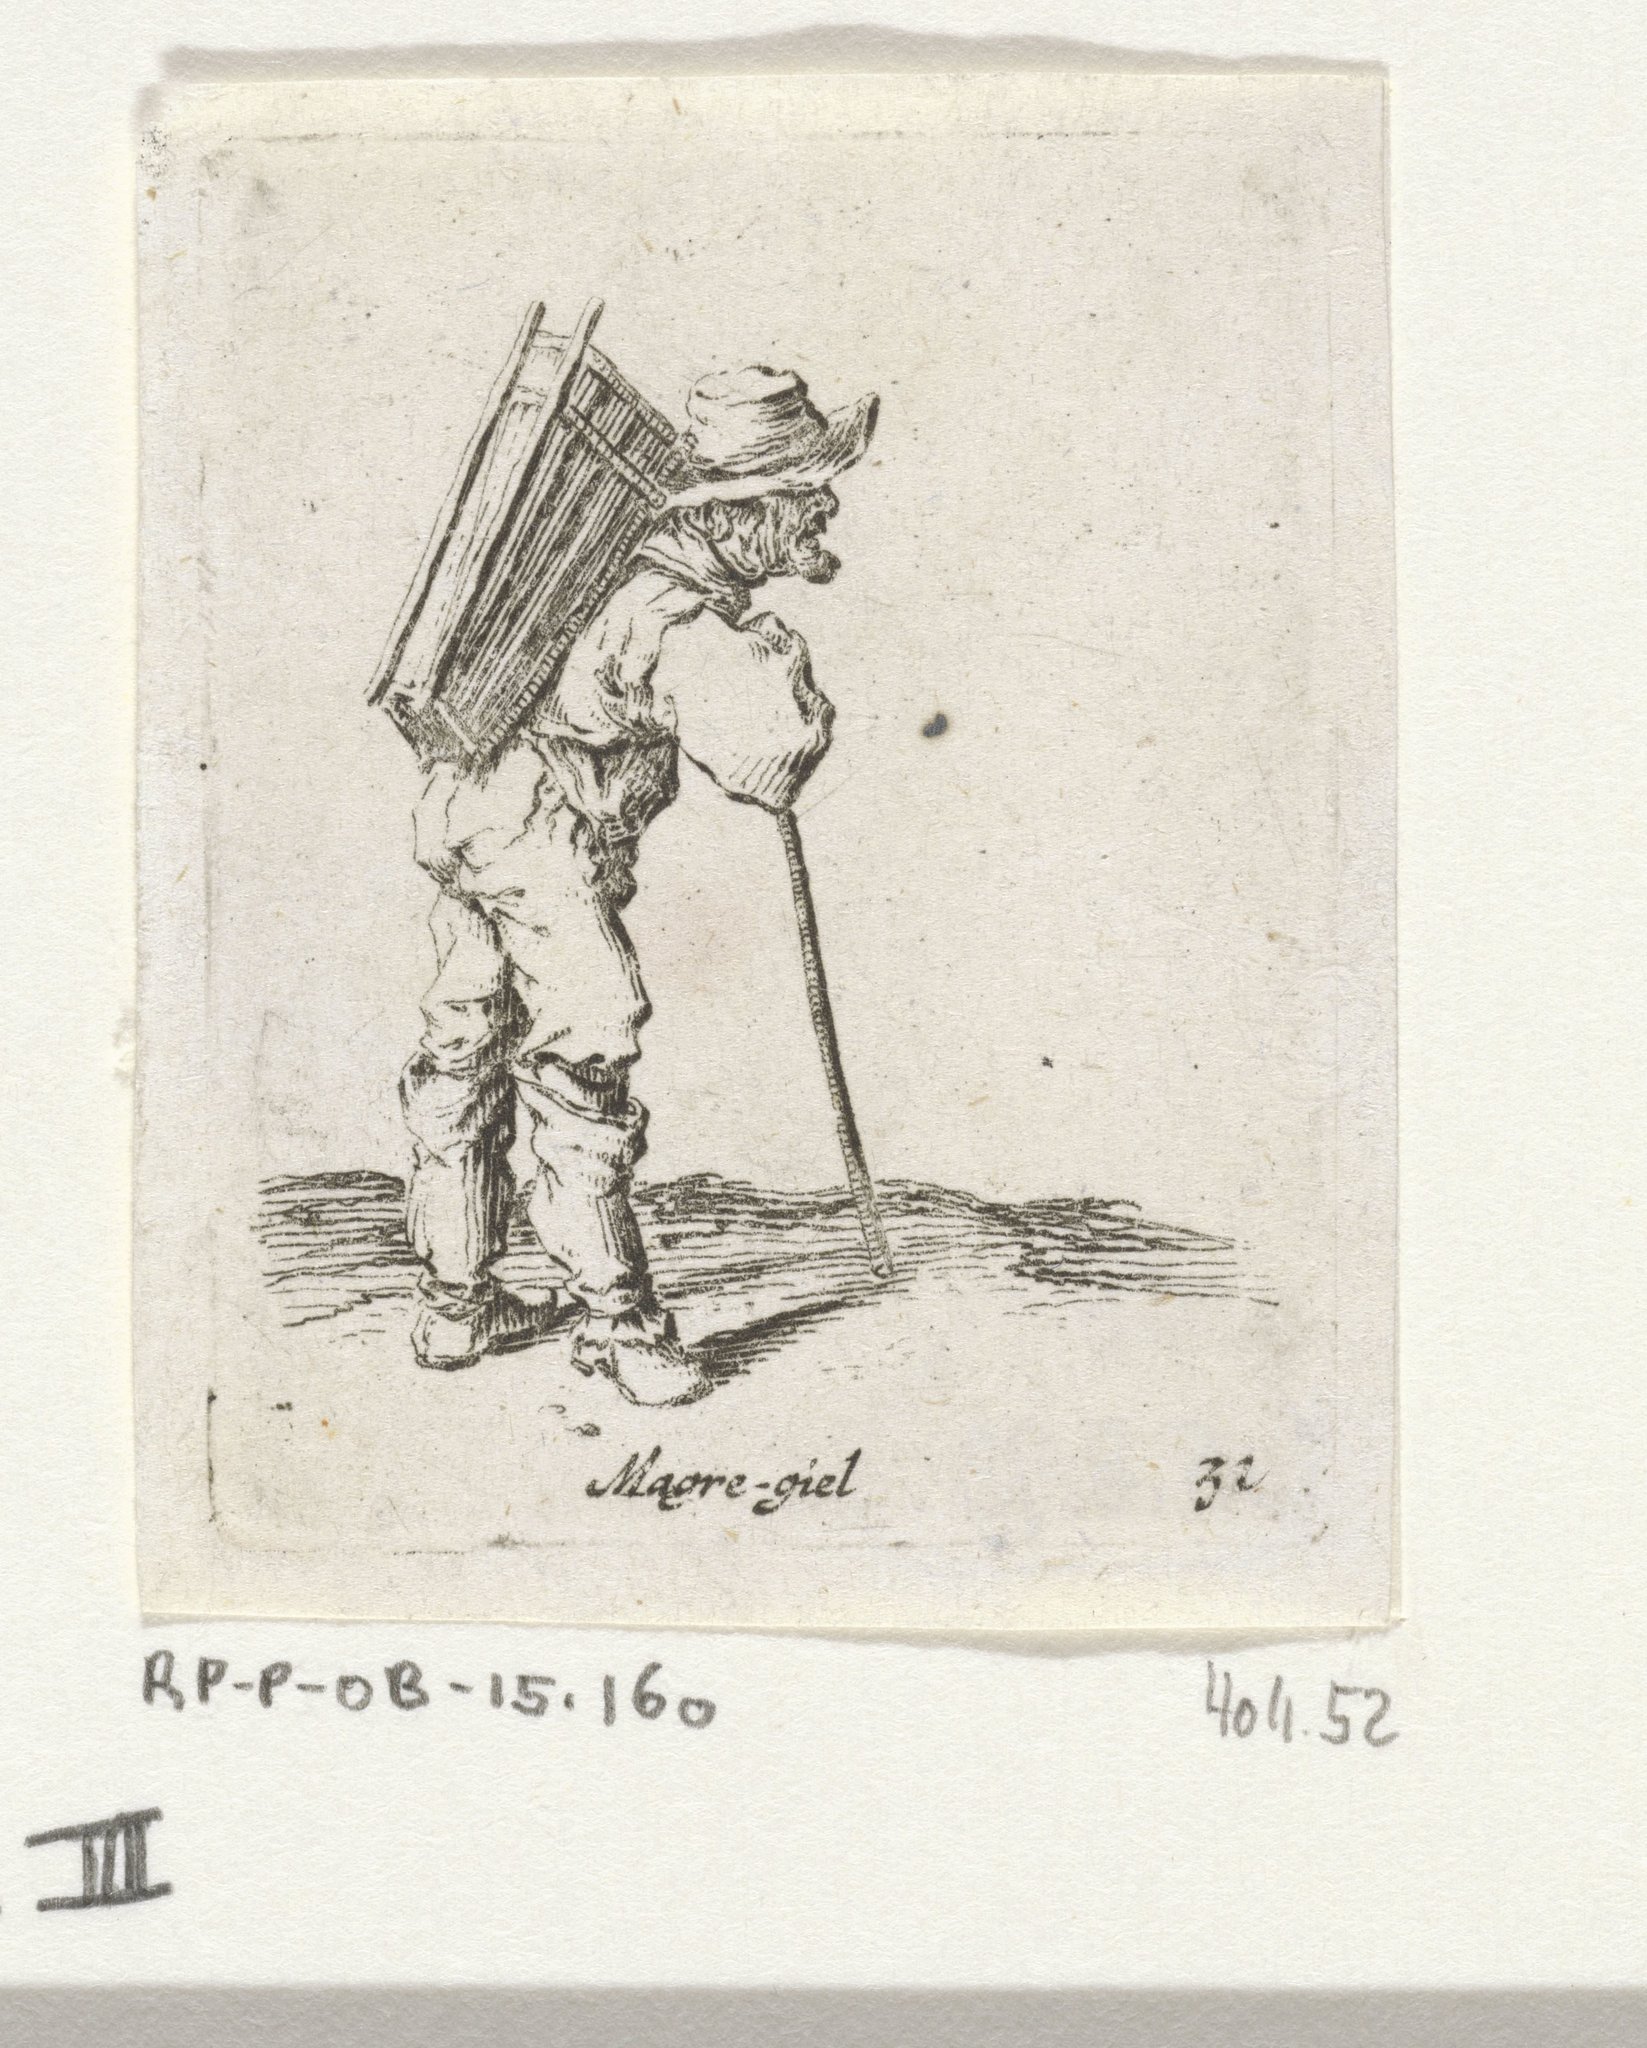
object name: print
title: Man met op zijn rug een mand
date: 1630-1706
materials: paper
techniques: etching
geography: netherlands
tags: walking-stick, staff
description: Een man (Magre-giel), met op zijn rug een mand, leunt op een wandelstok. De prent maakt deel uit van een serie van 32 prenten met genretaferelen.